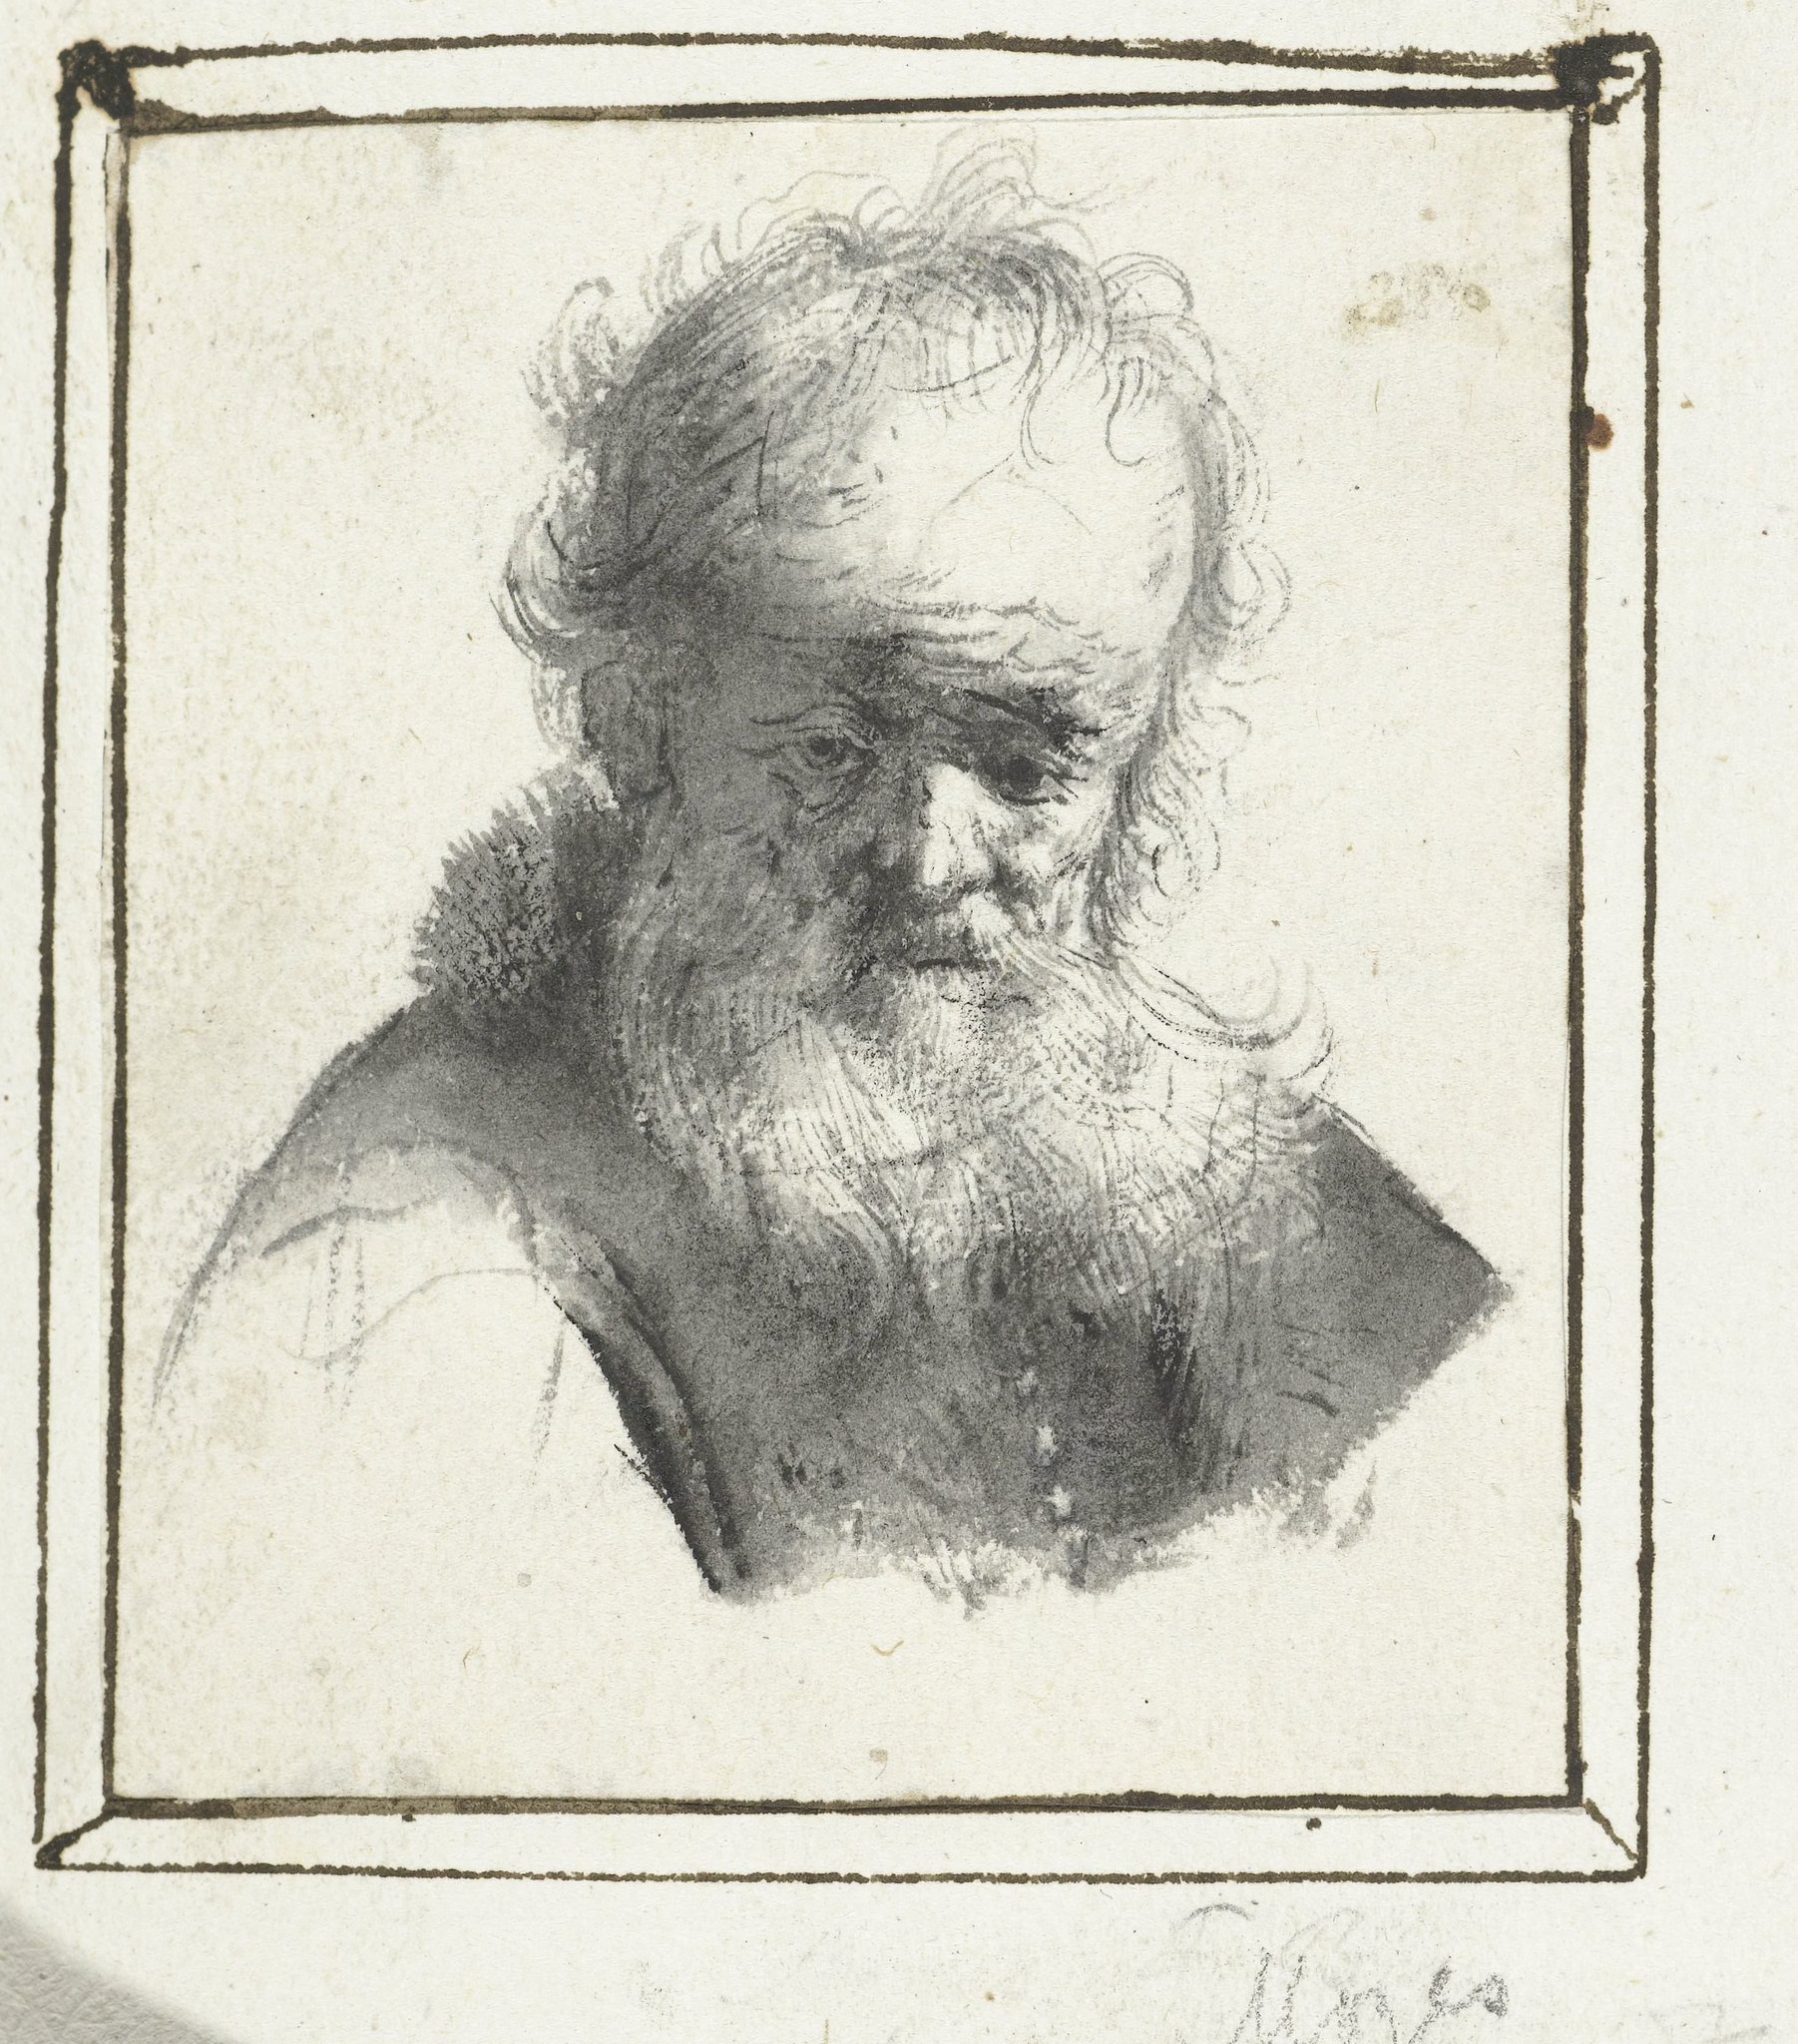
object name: drawing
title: Hoofd van een bebaarde oude man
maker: moses ter borch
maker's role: draughtsman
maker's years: 1645-1667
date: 1630-1667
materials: chalk, ink, paper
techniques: brush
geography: zwolle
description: Tekening naast twee andere tekeningen in het Familie-plakboek geplakt. Vrije kopie naar Rembrandts ets 'Buste van een oude man met vloeiende baard en witte mouw' uit c. 1630 (B. 291).